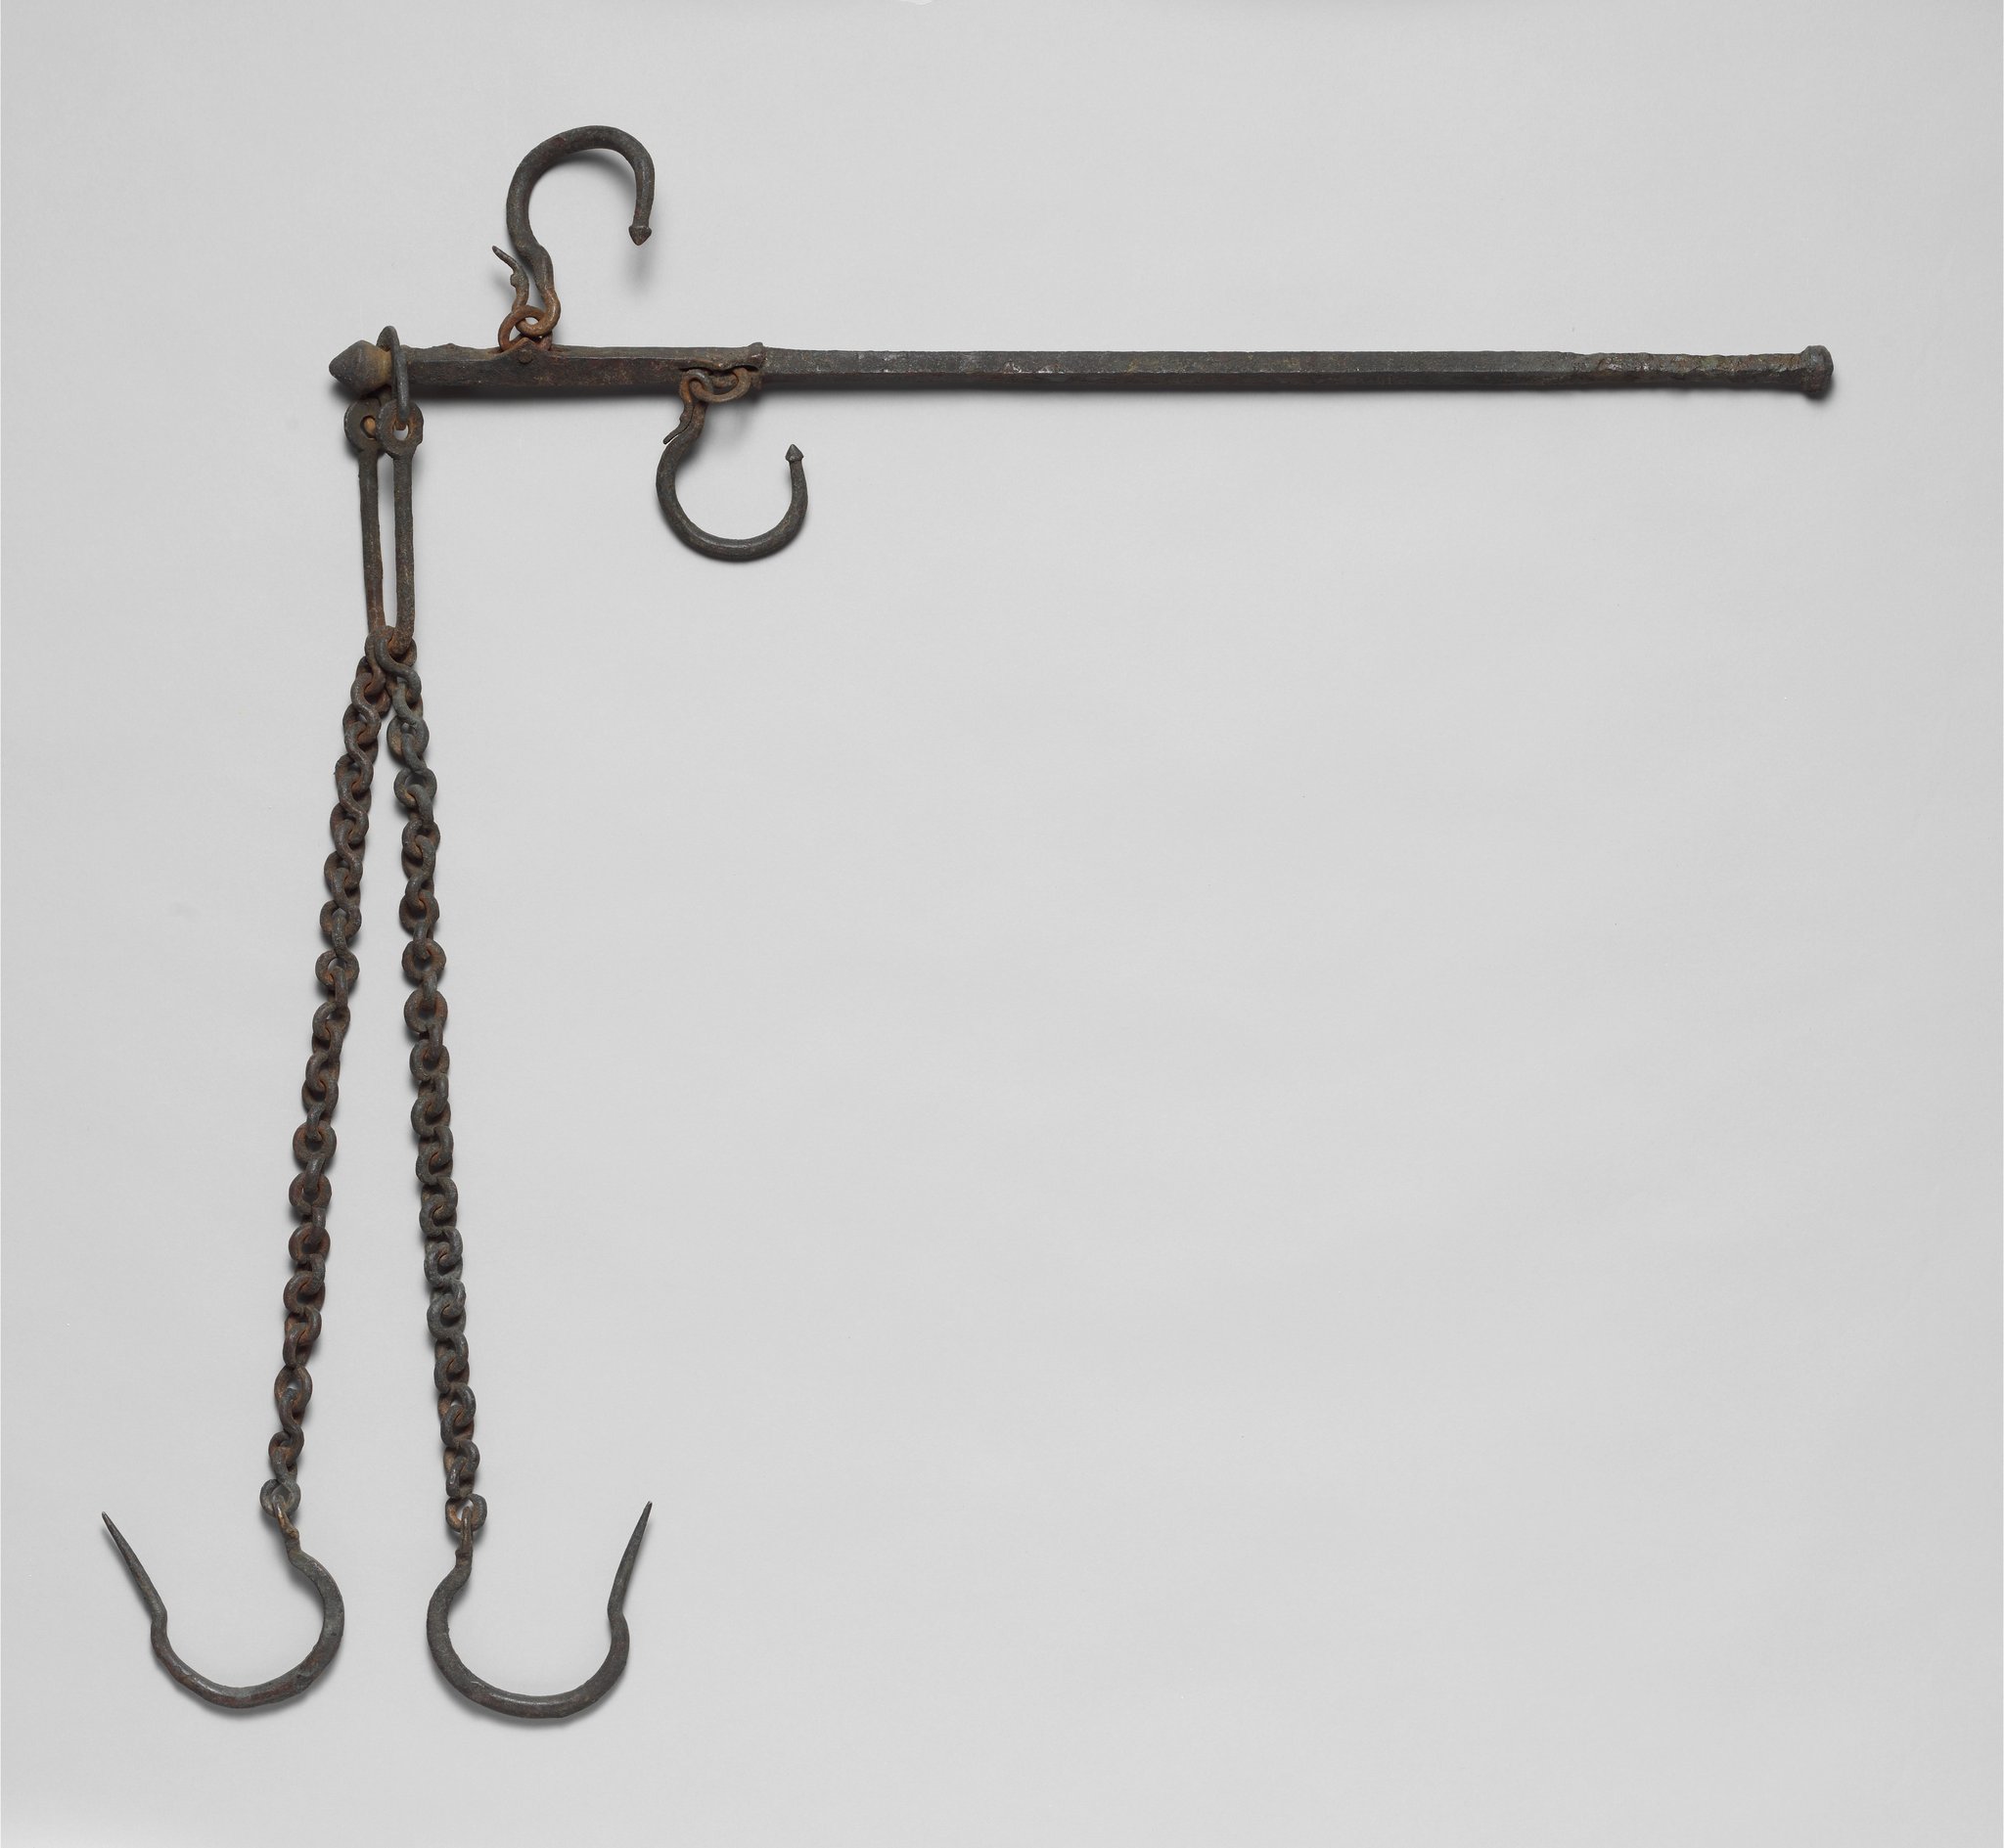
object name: steelyard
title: Bronze steelyard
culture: roman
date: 101-400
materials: bronze